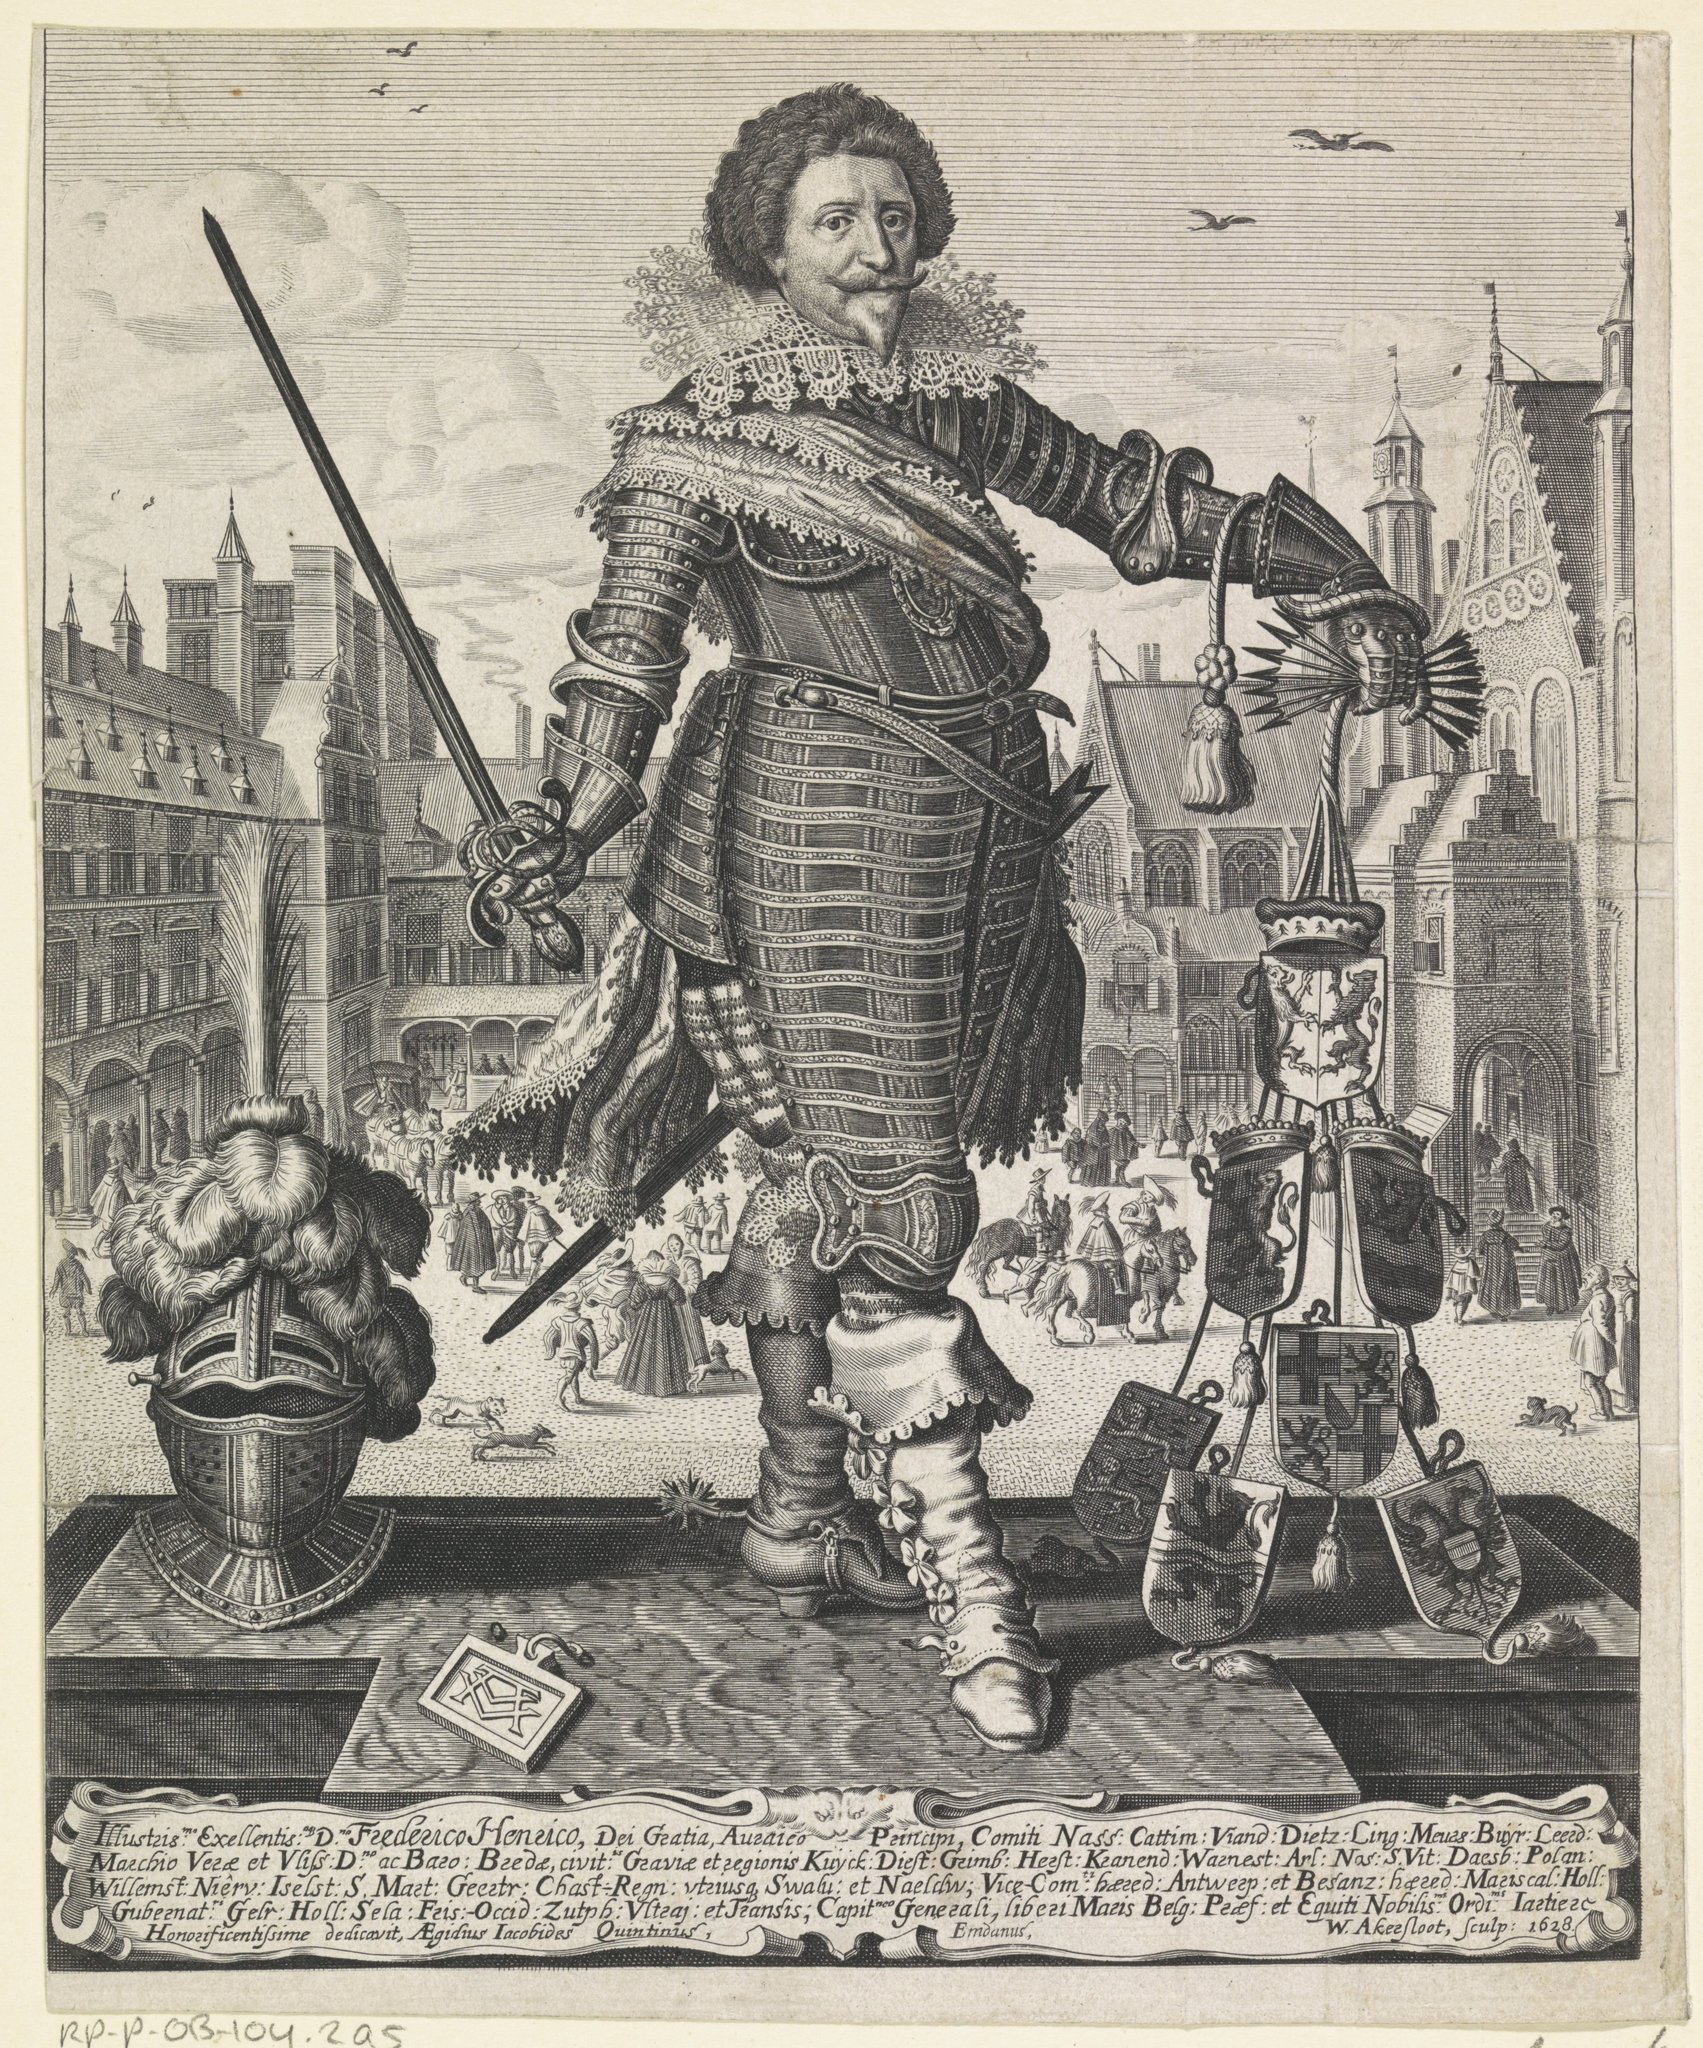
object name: print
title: Portret van Frederik Hendrik, prins van Oranje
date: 1628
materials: paper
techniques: engraving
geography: northern netherlands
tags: delft, the hague, frederick henry (prince of orange)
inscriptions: collector's mark: Lugt 2228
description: Portret van Frederik Hendrik, ten voeten uit in wapenrusting, staande op een bordes. In zijn rechterhand een degen, in zijn linker een bundel pijlen en een touw. Aan het touw zijn de wapens van de Zeven Provinciën vastgemaakt. Op de achtergrond het bevolkte Binnenhof te Den Haag. In een cartouche vier regels Latijnse tekst.